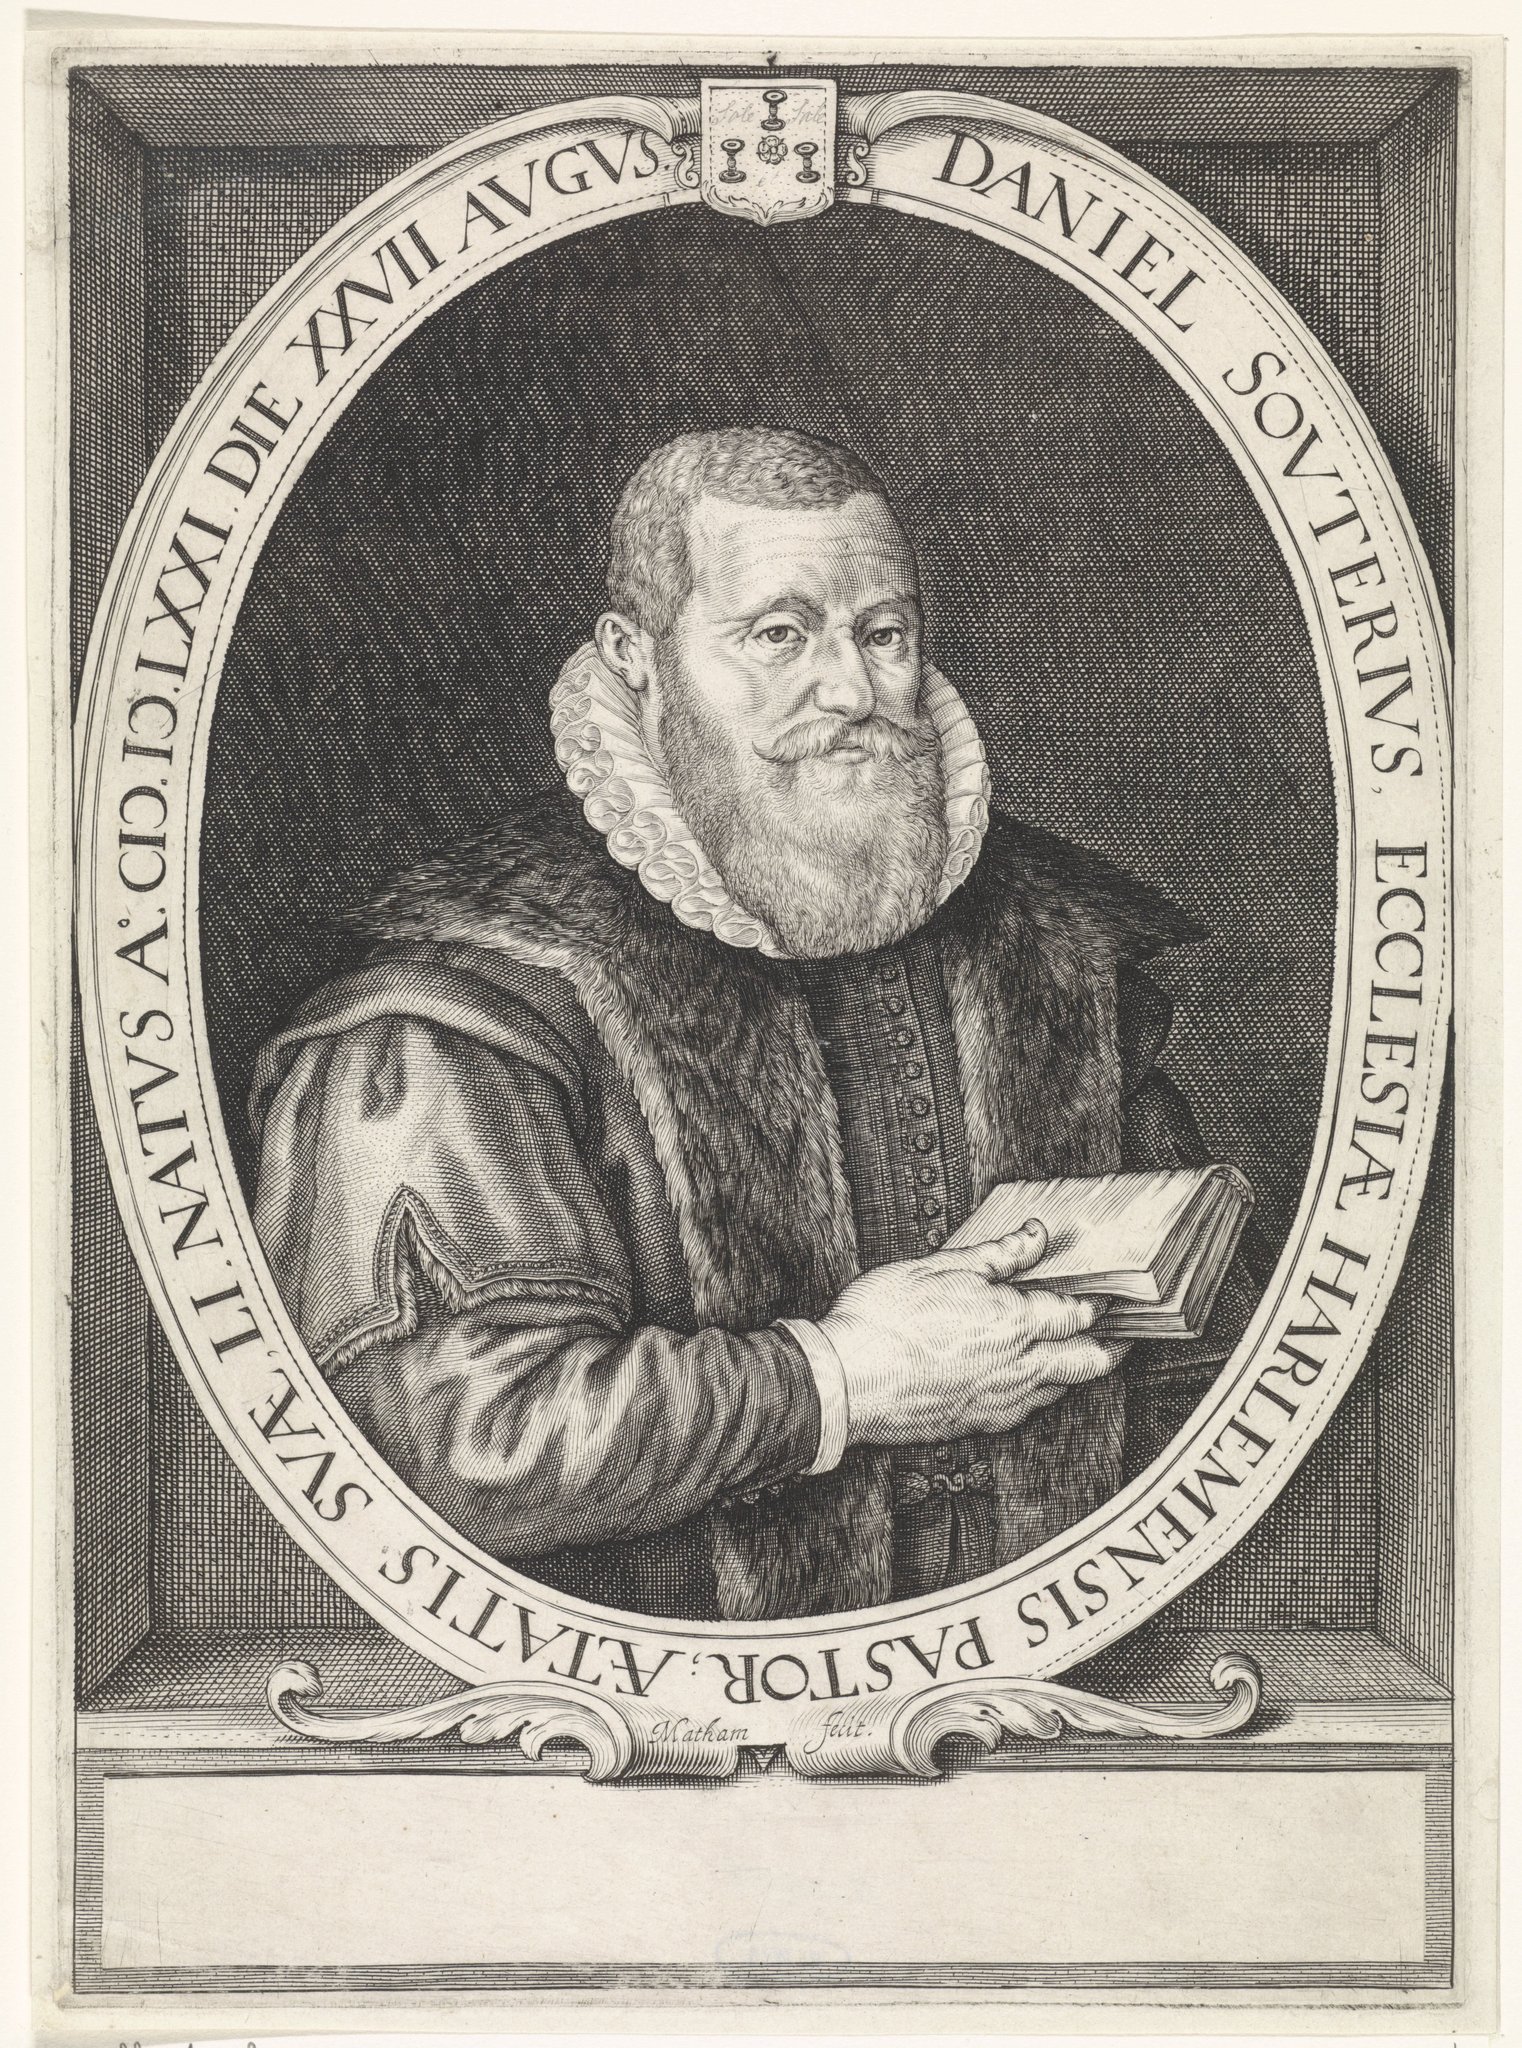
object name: print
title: Portret van Daniel Souterius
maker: jacob matham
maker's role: draughtsman, print maker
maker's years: 1571-1631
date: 1621-1623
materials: paper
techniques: engraving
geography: haarlem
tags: daniel souterius, historical persons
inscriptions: collector's mark: Lugt 2228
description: Portret van de schrijver en predikant Daniel Souterius. Ter halver lijve rechts gewend, met snor en baard, staande, met geplooide kraag en toga met bont omzoomd. In de rechterhand houdt hij een boek. Bovenaan op de ovale randlijst zijn wapenschild.